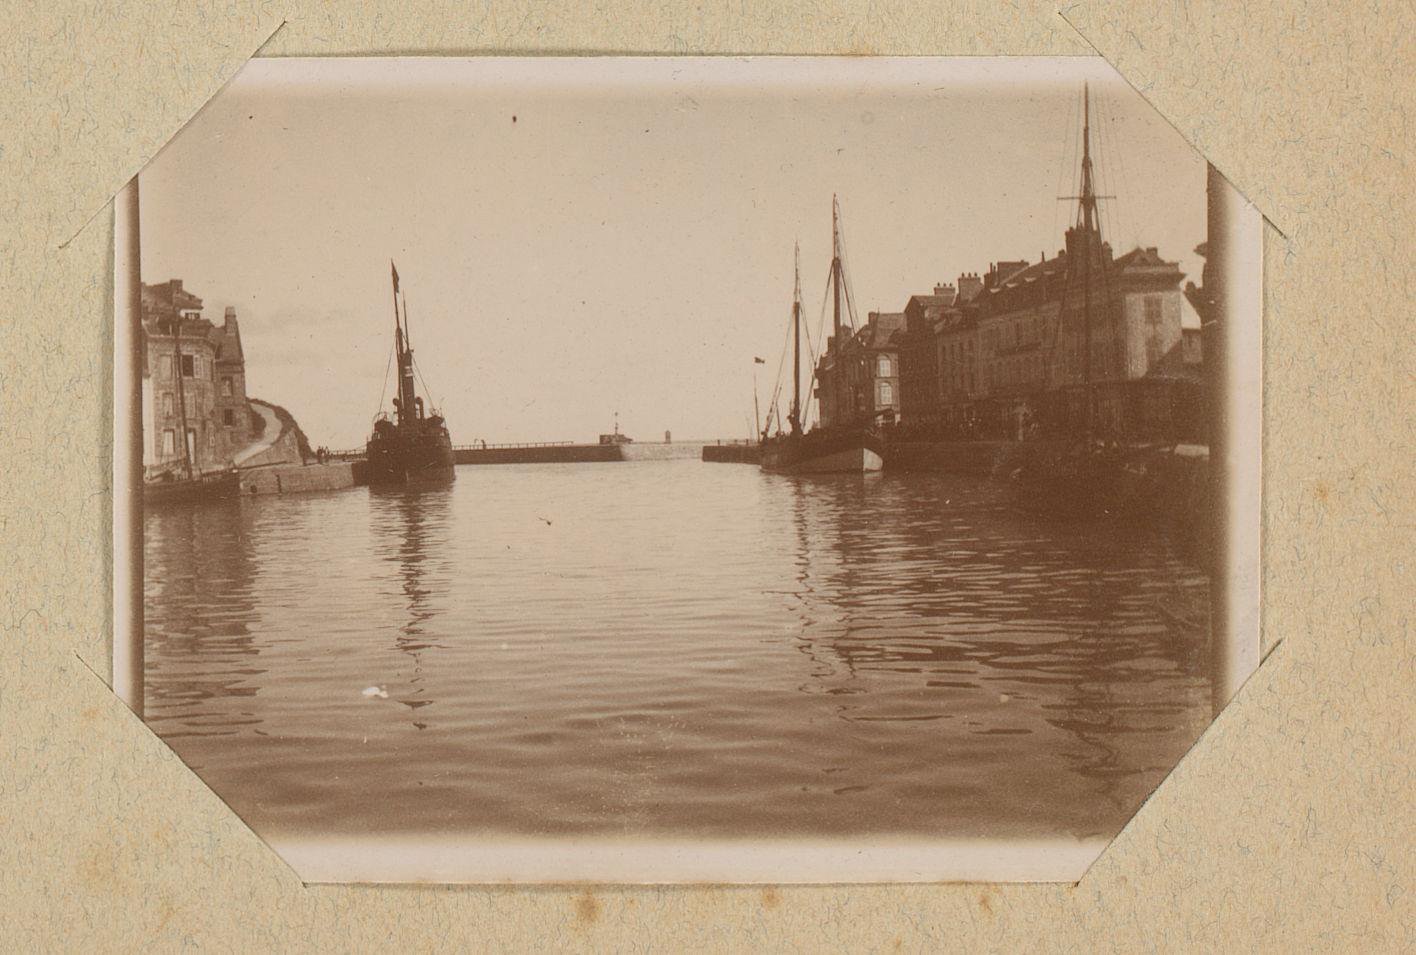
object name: album leaf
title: Schepen in een haven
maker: Anonymous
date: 1895-1900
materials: paper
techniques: gelatin silver print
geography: france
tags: harbour, france